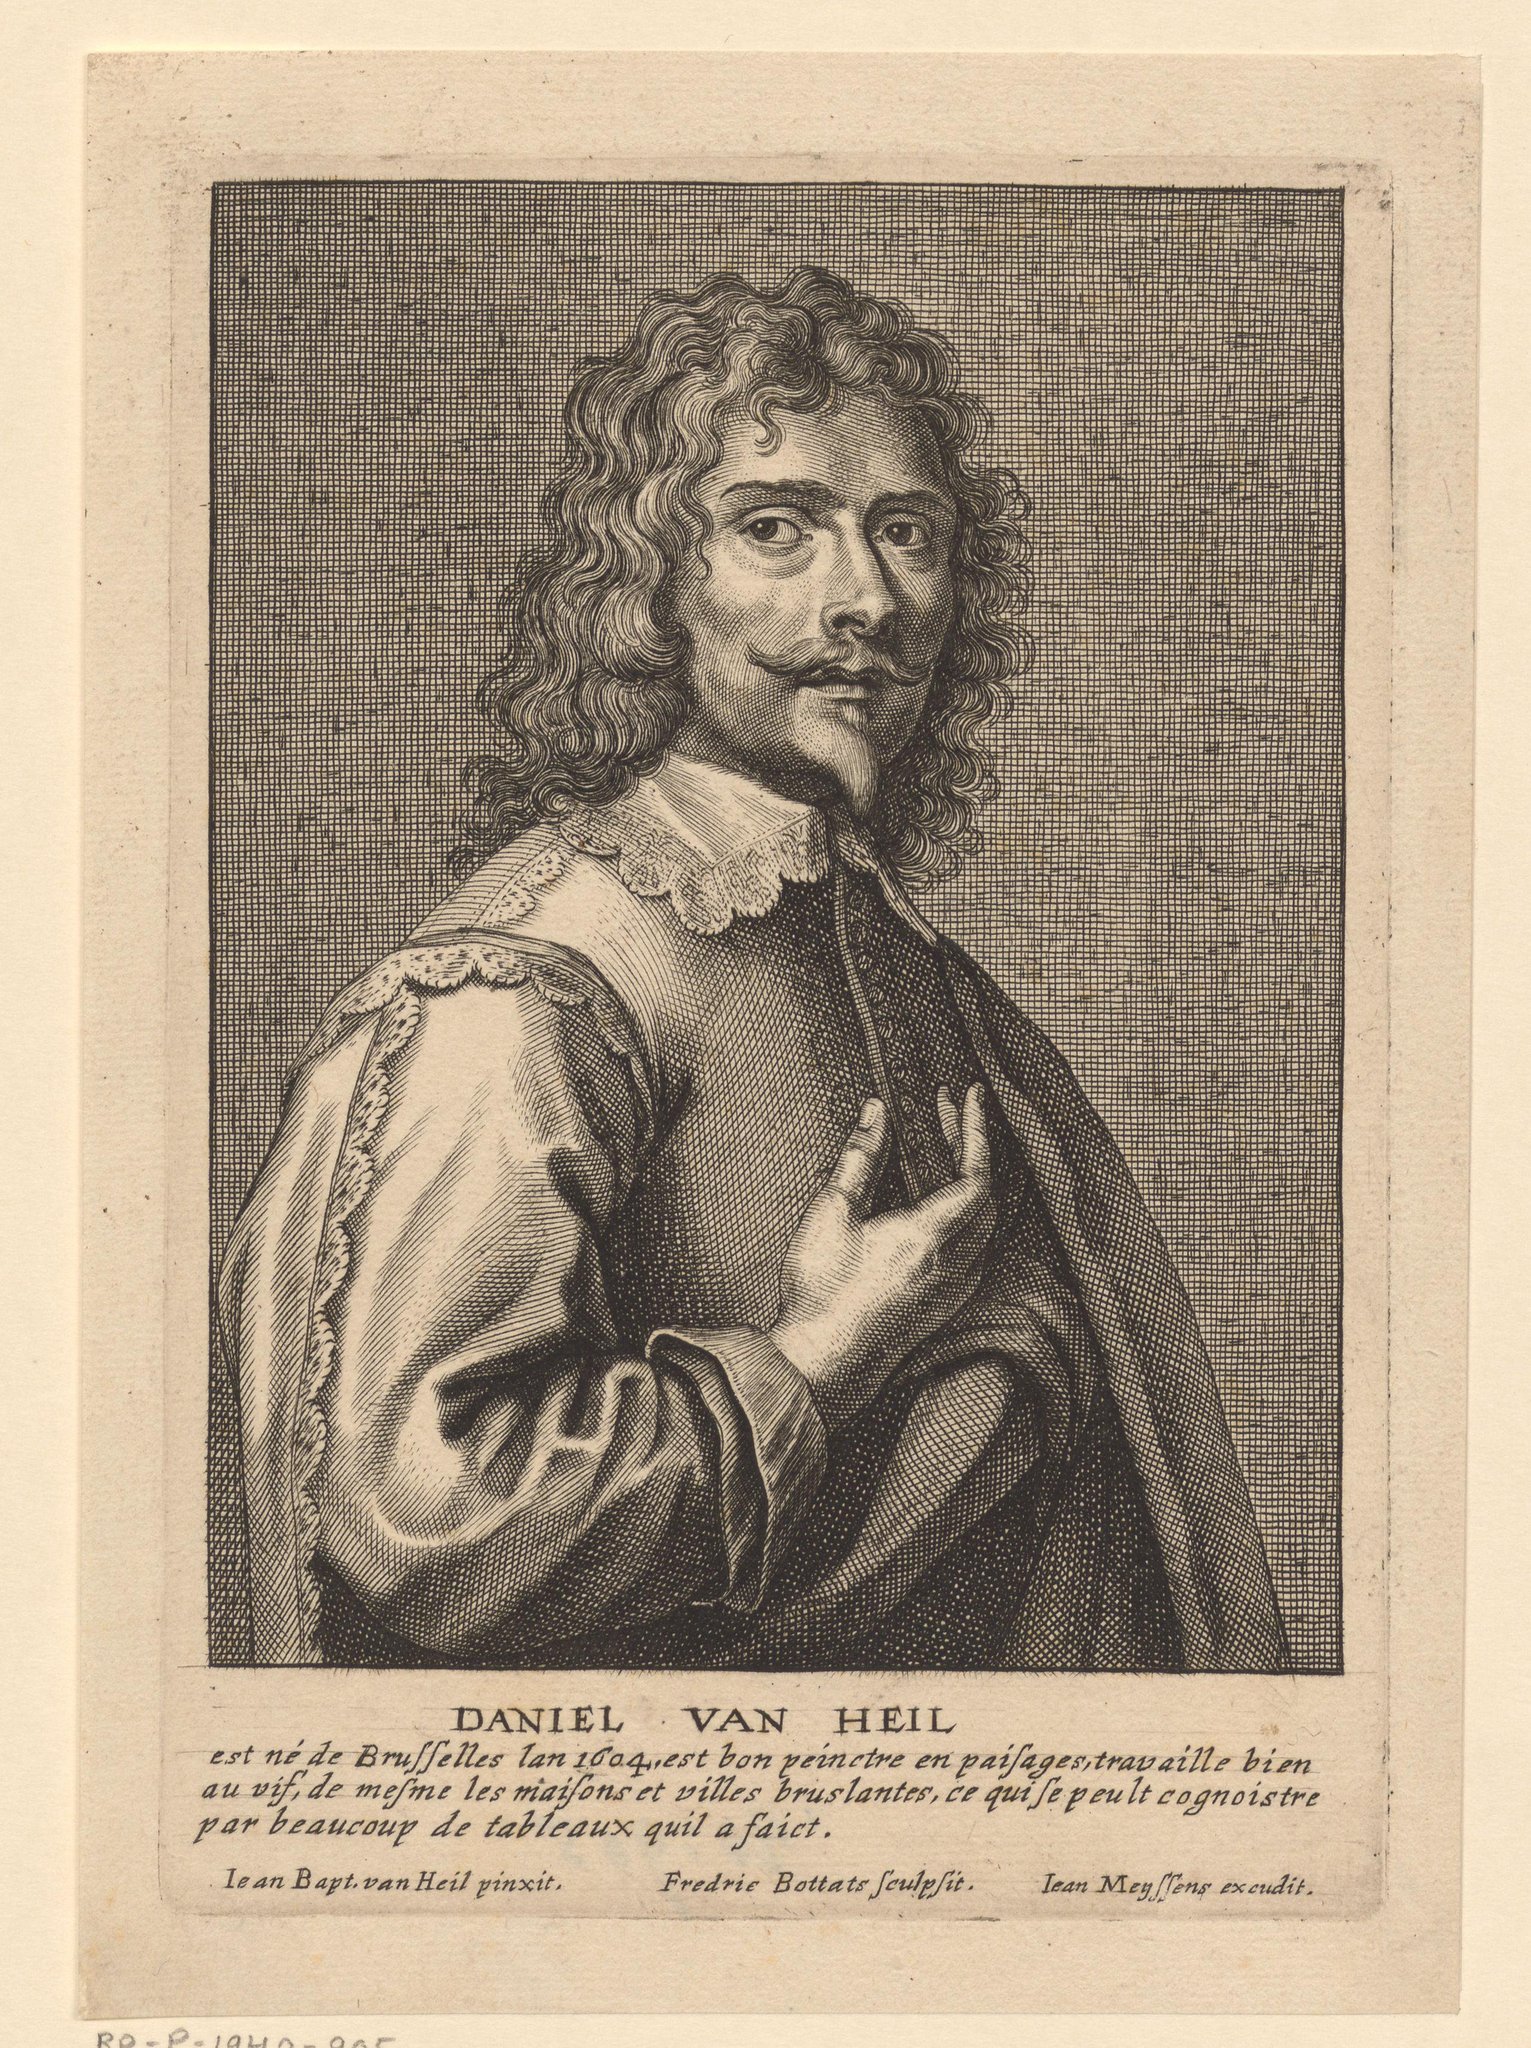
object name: print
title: Image de divers hommes desprit sublime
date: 1649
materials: paper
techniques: engraving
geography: antwerp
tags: brussels, painter, daniël van heil, historical persons, portrait, self-portrait of painter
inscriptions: collector's mark: Lugt 2760, collector's mark: Lugt 2228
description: Prent ook gebruikt in: Bie, Cornelis de. Het gulden cabinet vande edele vry schilder-const (...). Antwerpen: Juliaen van Montfort, 1662.